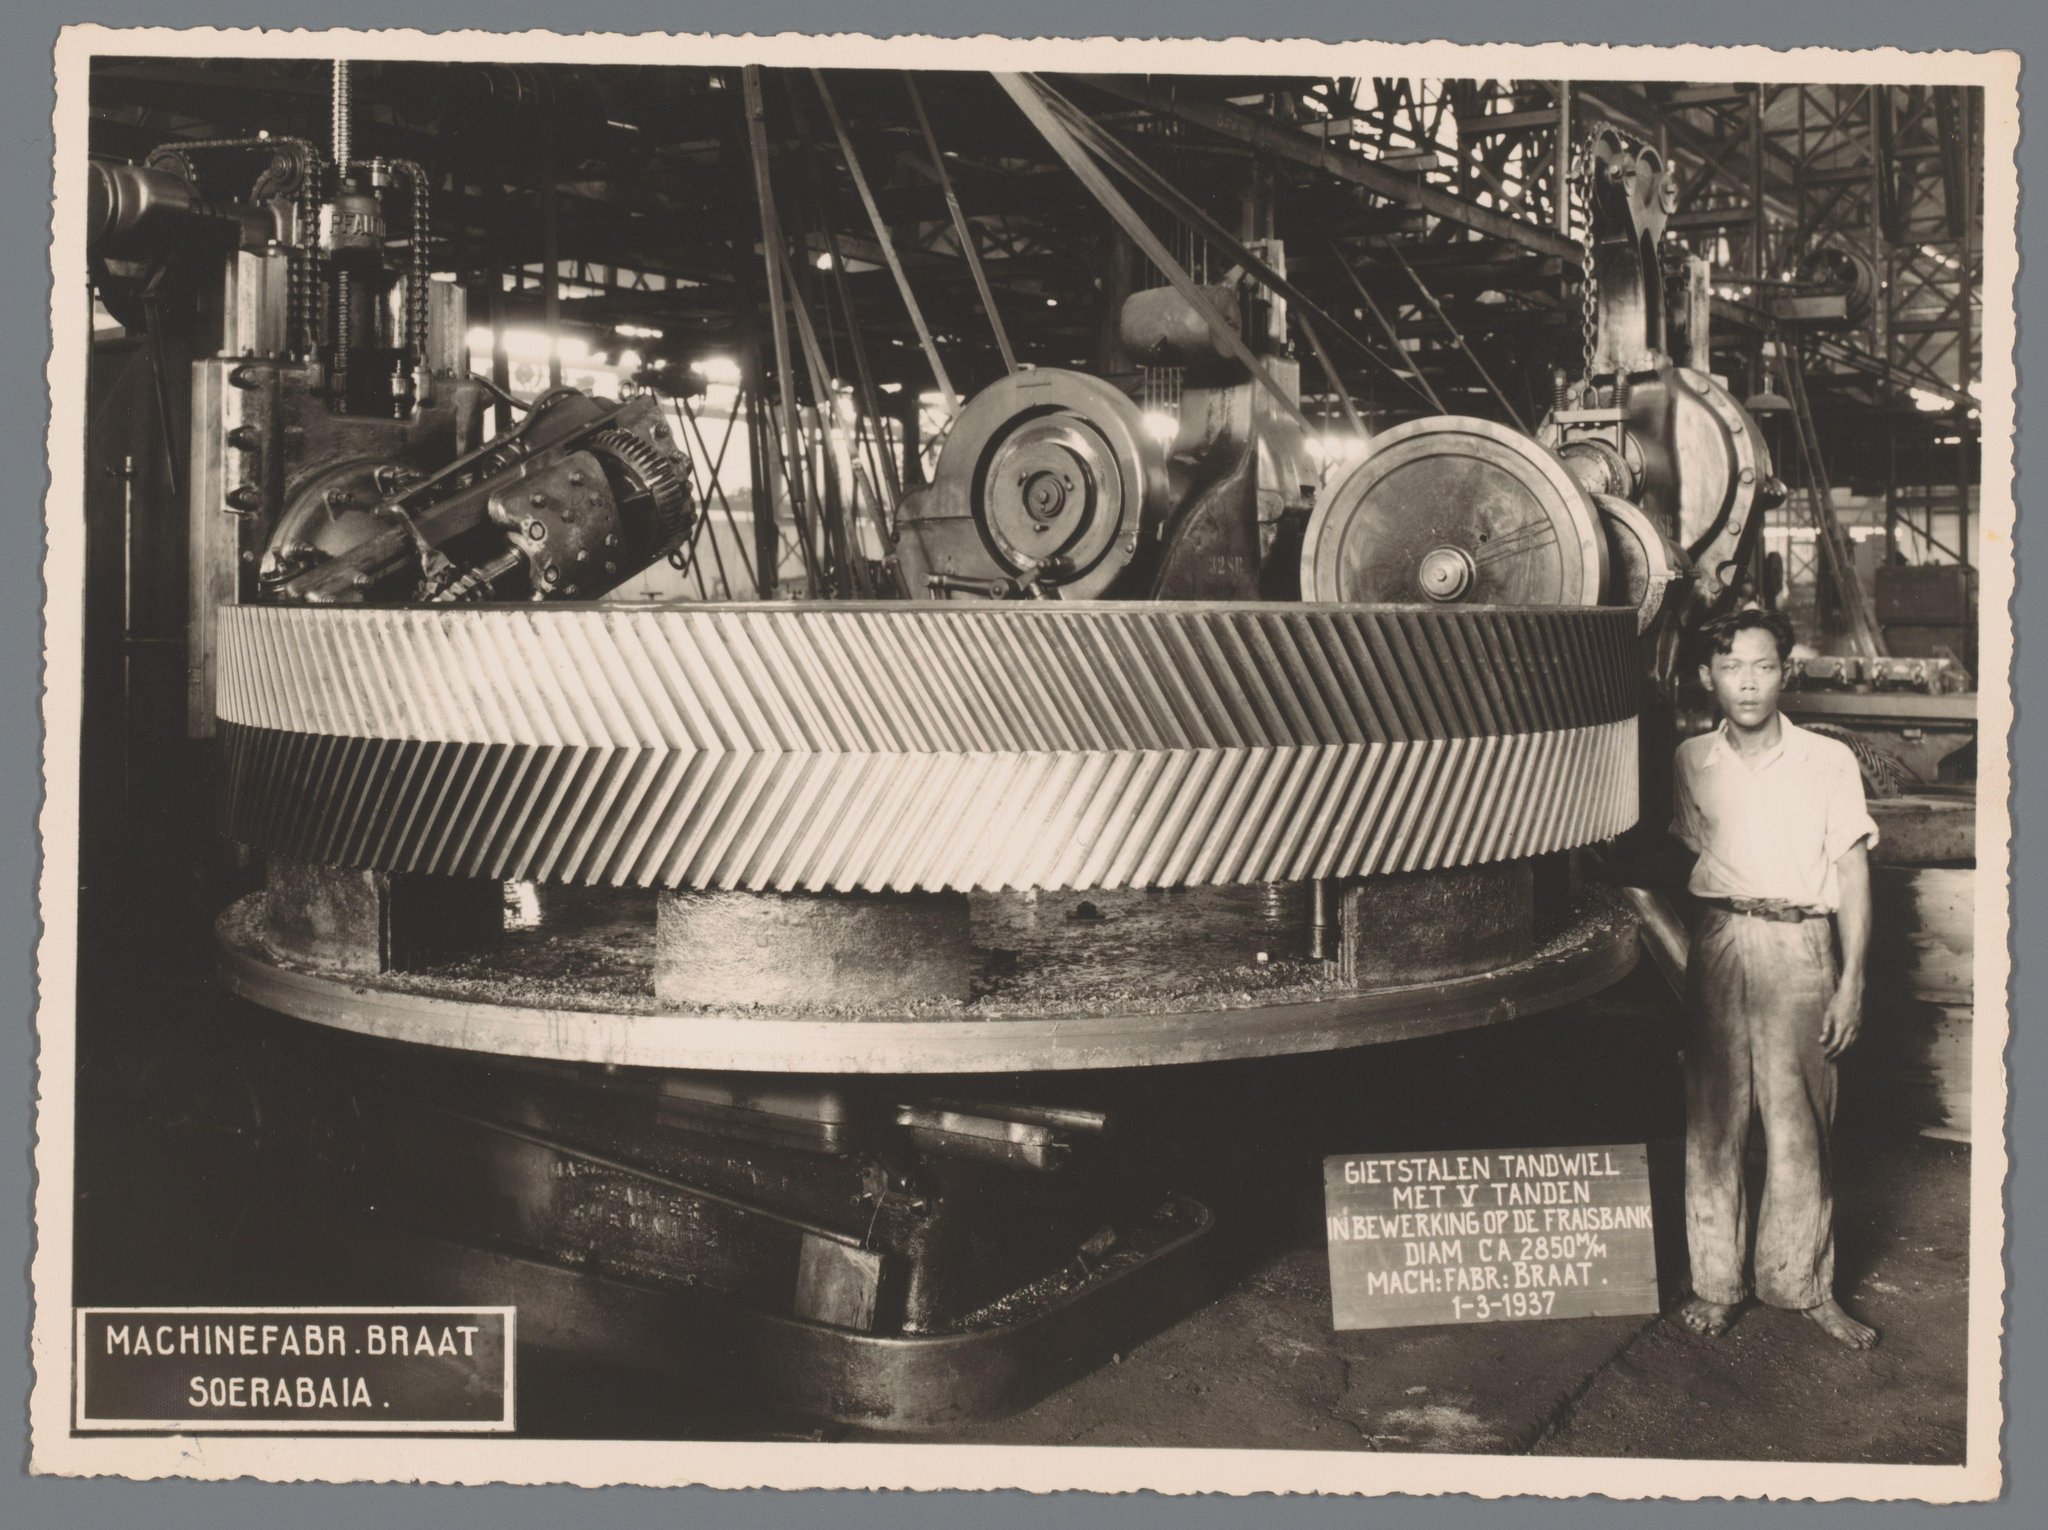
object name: photograph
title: Tandwiel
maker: Anonymous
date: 1937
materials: photographic support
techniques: gelatin silver print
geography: surabaya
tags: colonial system, machines; parts of machines; tools and appliances, factory-interior, machine shop (+ men (labourers)), java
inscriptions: date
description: Gietstalen tandwiel in bewerking op de freesbank in 1937 en bestemd voor de Suikerfabriek Gempolkerep. Onderdeel van de multomap met foto's van machines van de N.V. Machinefabriek Braat te Soerabaja, Soekaboemi en Jogyakarta, uit de periode 1908-1942.